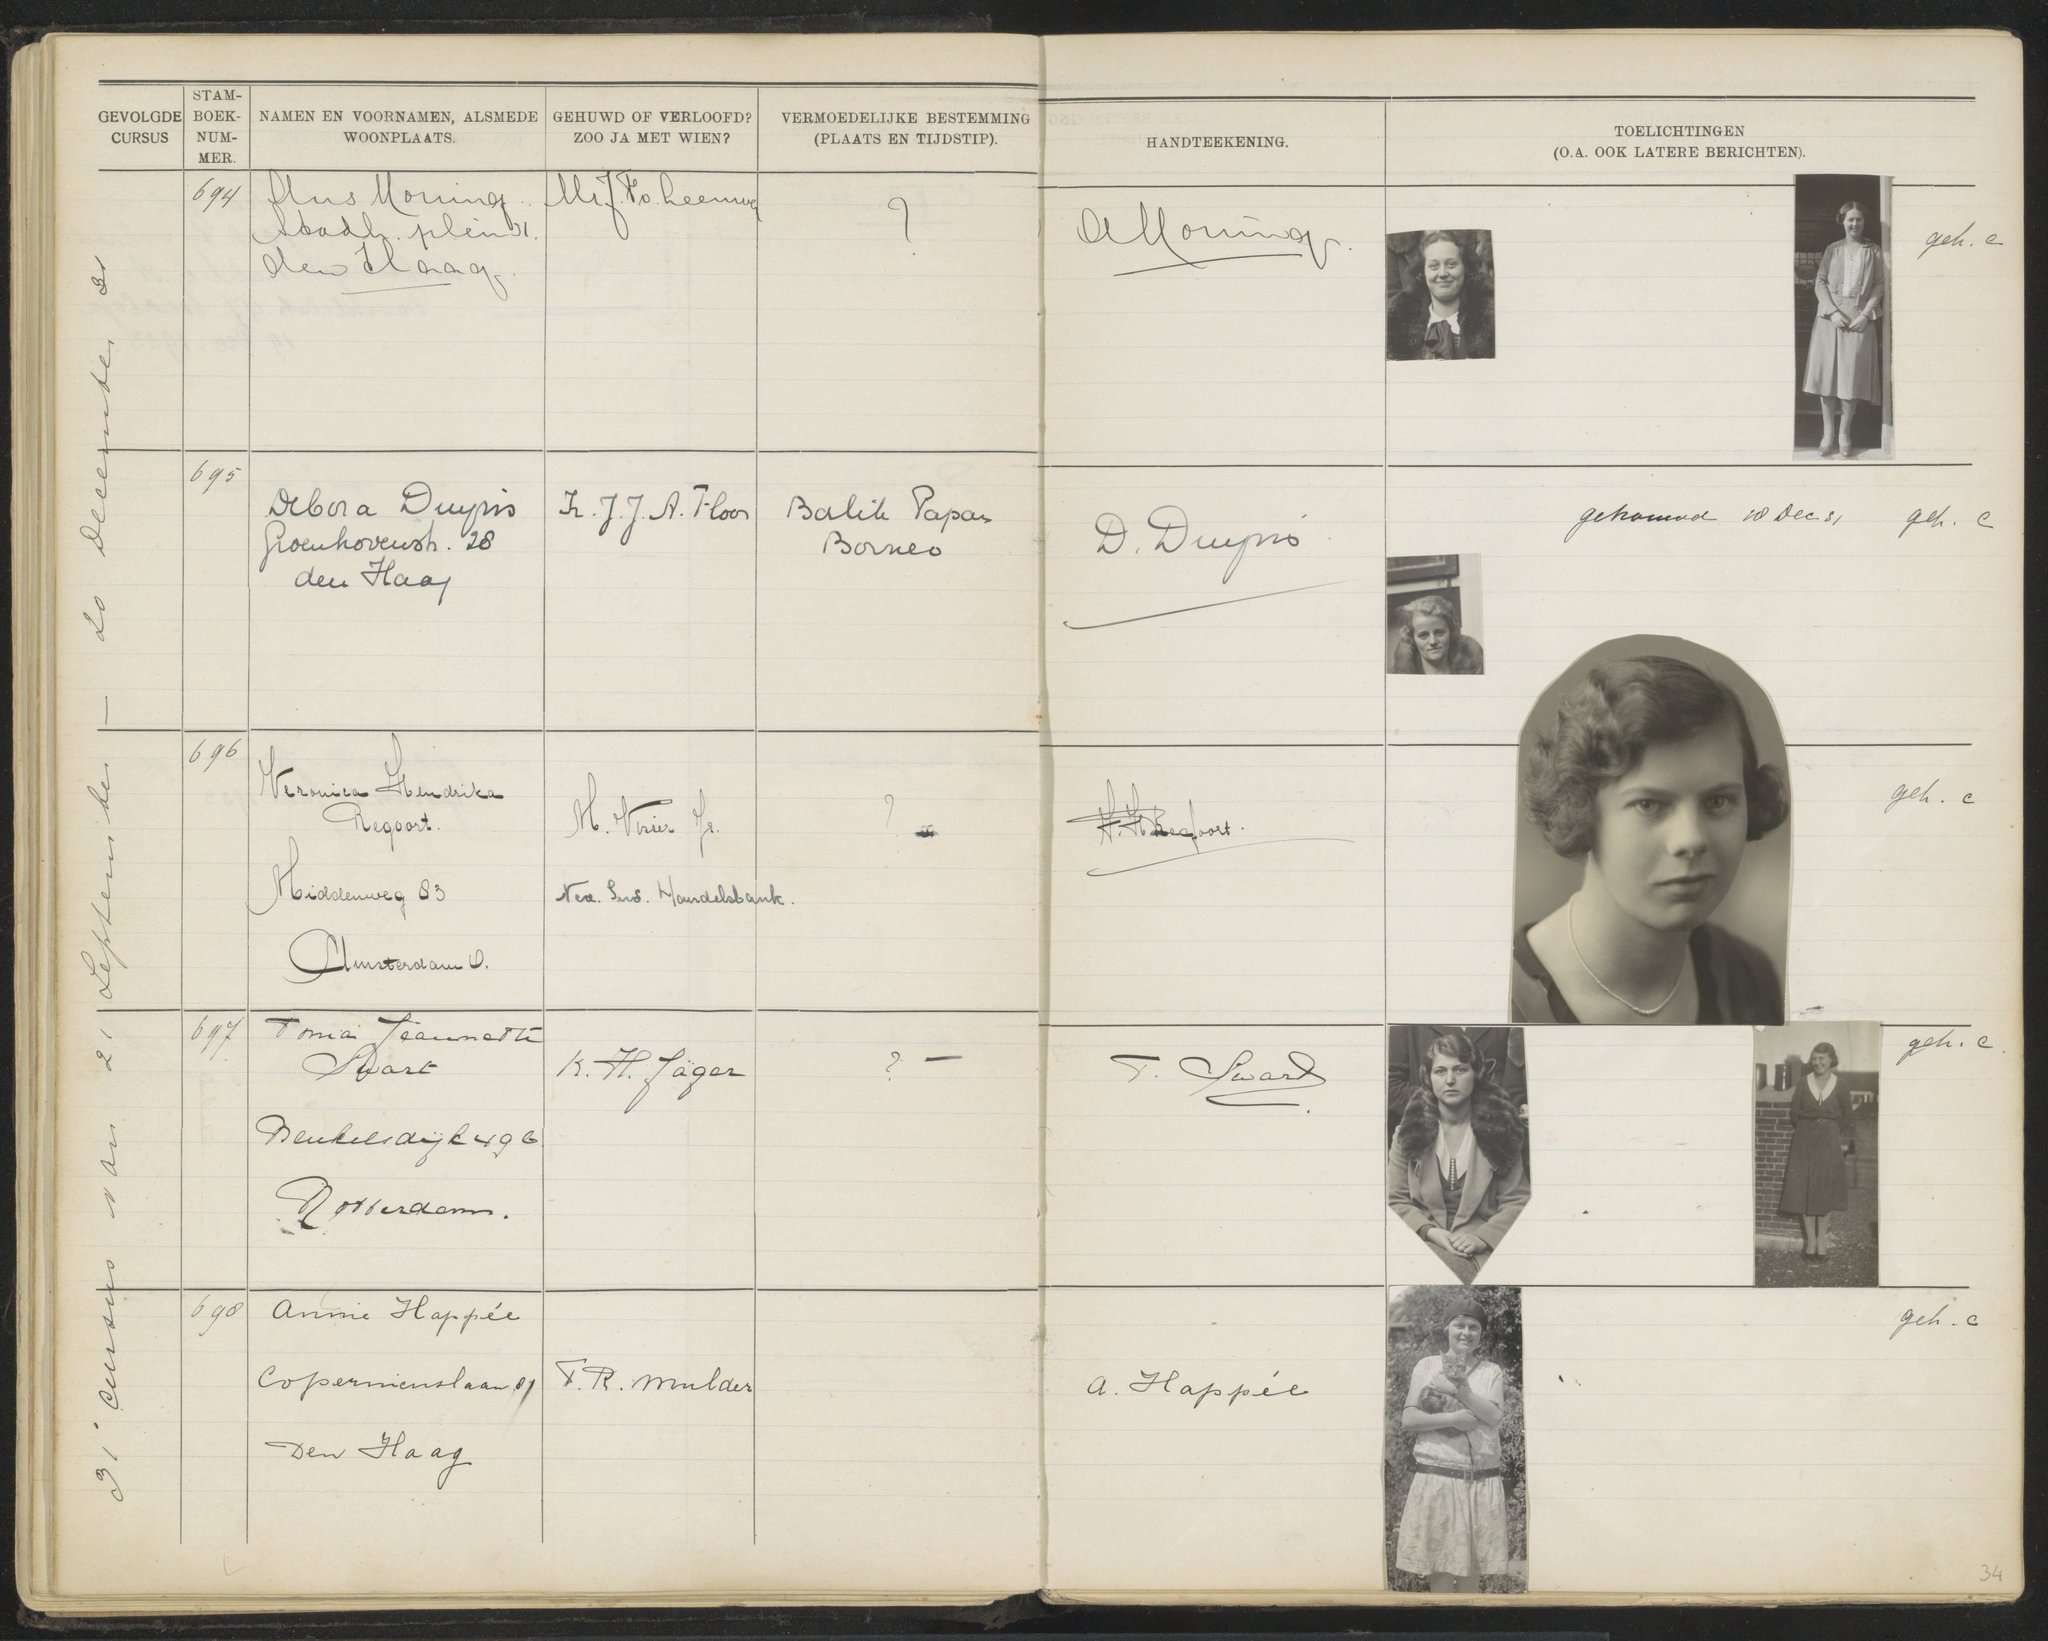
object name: photograph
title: Blad 34 uit Stamboek van de leerlingen der Koloniale School voor Meisjes en Vrouwen te 's-Gravenhage deel II (1930-1949)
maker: Anonymous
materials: paper, photographic support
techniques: photography, printing, writing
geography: the hague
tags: further education (+ pupil), further education, the hague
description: Twee pagina's met gegevens van de deelnemers aan de 31e driemaandelijkse cursus van 21 september tot en met 20 december 1931, stamboeknummers 694 tot en met 698. Onderdeel van Stamboek van de leerlingen der Koloniale School voor Meisjes en Vrouwen te 's-Gravenhage deel II (1930-1949).